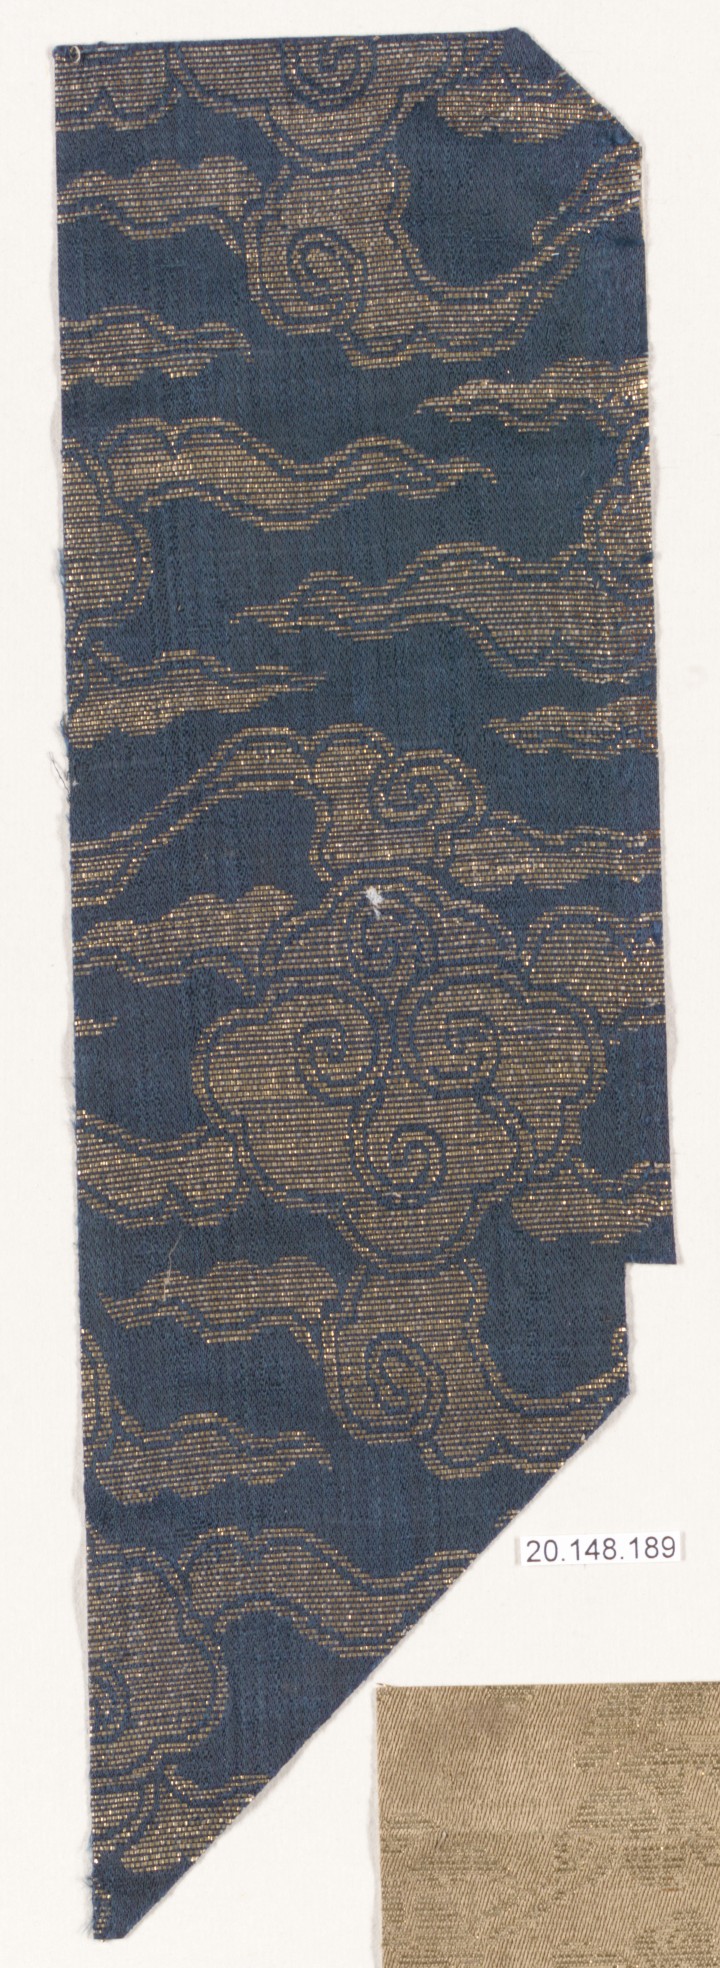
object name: piece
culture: japanese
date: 1701-1800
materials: silk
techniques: compound weave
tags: clouds